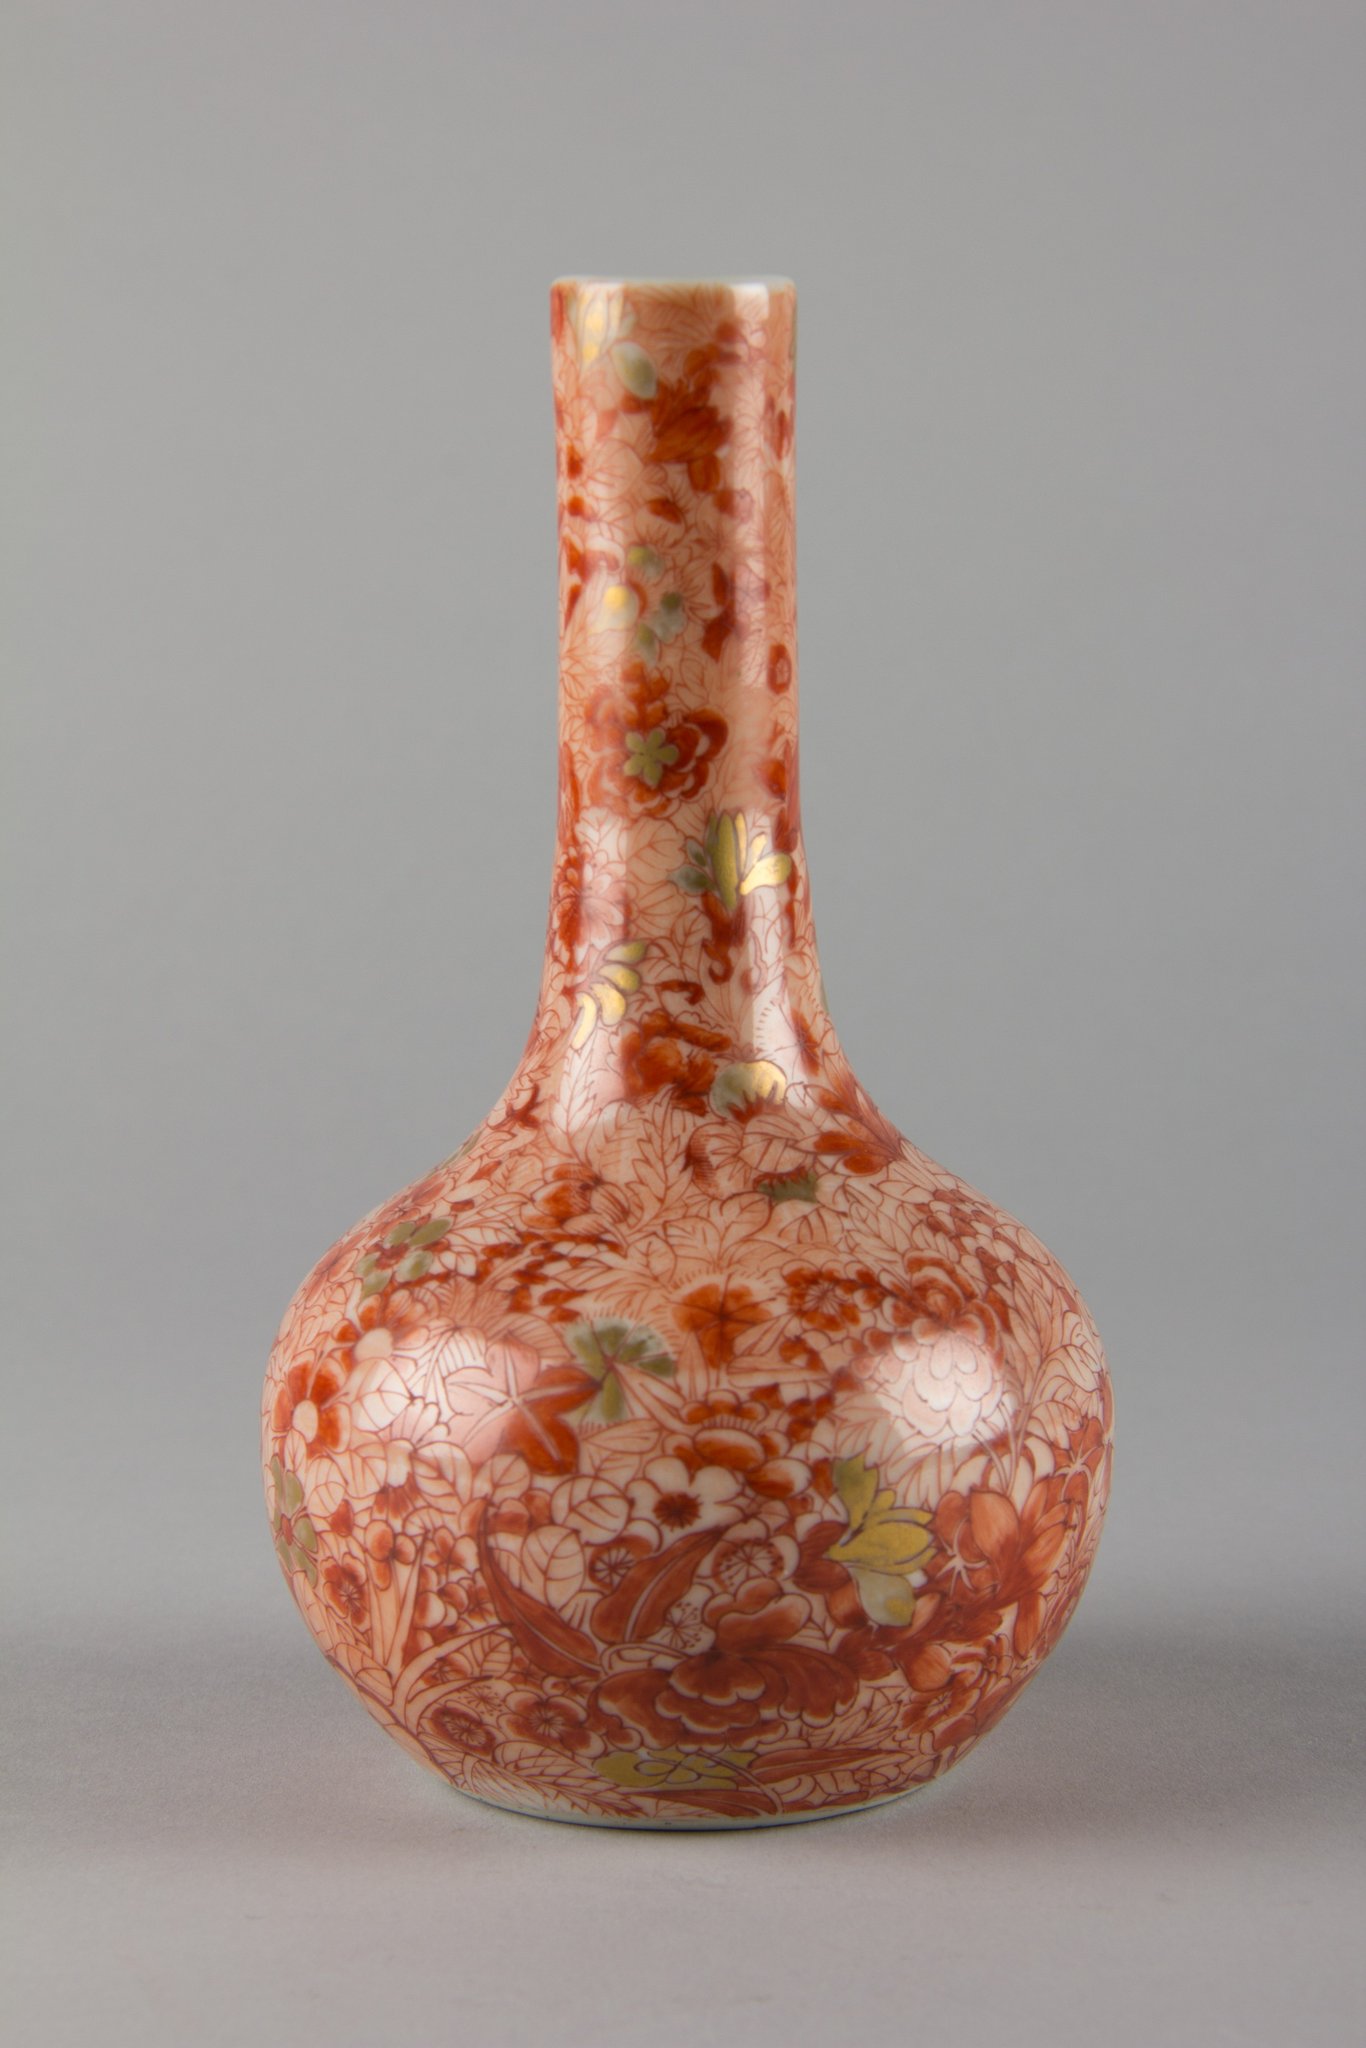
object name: vase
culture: chinese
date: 1736-1795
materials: porcelain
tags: flowers